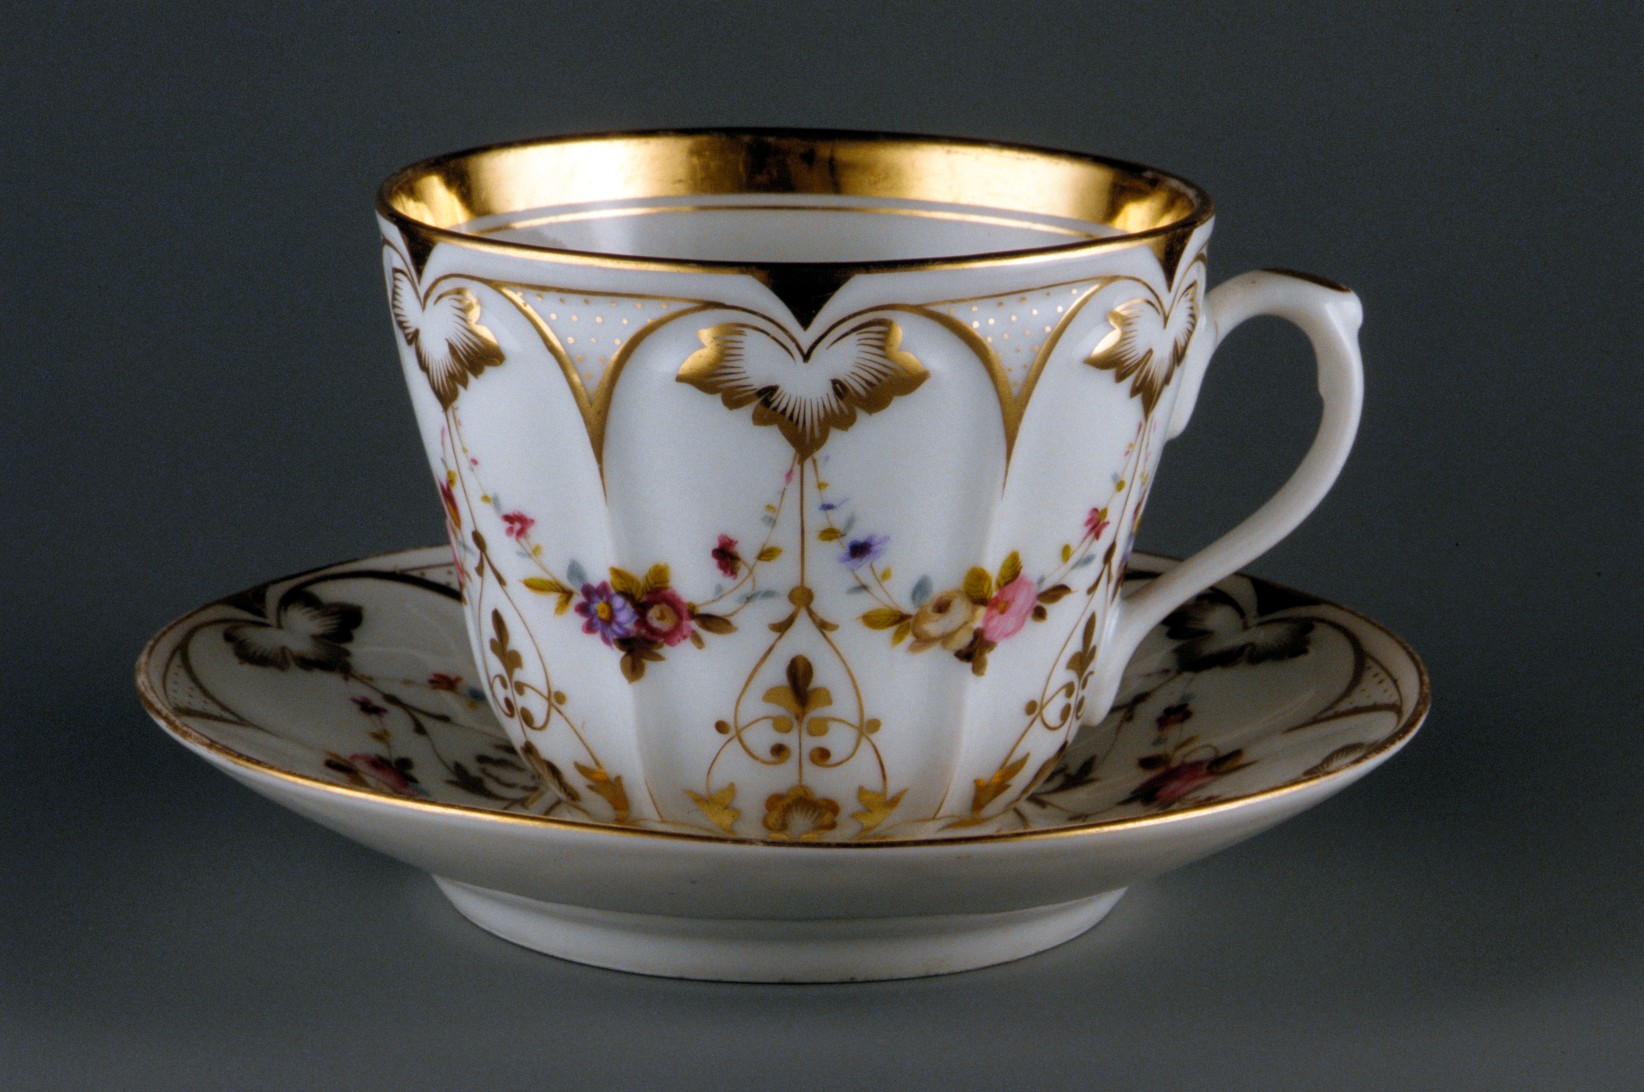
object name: cup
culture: american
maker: charles cartlidge and company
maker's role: maker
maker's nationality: american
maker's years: 1848-1856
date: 1848-1856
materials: porcelain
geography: united states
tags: flowers